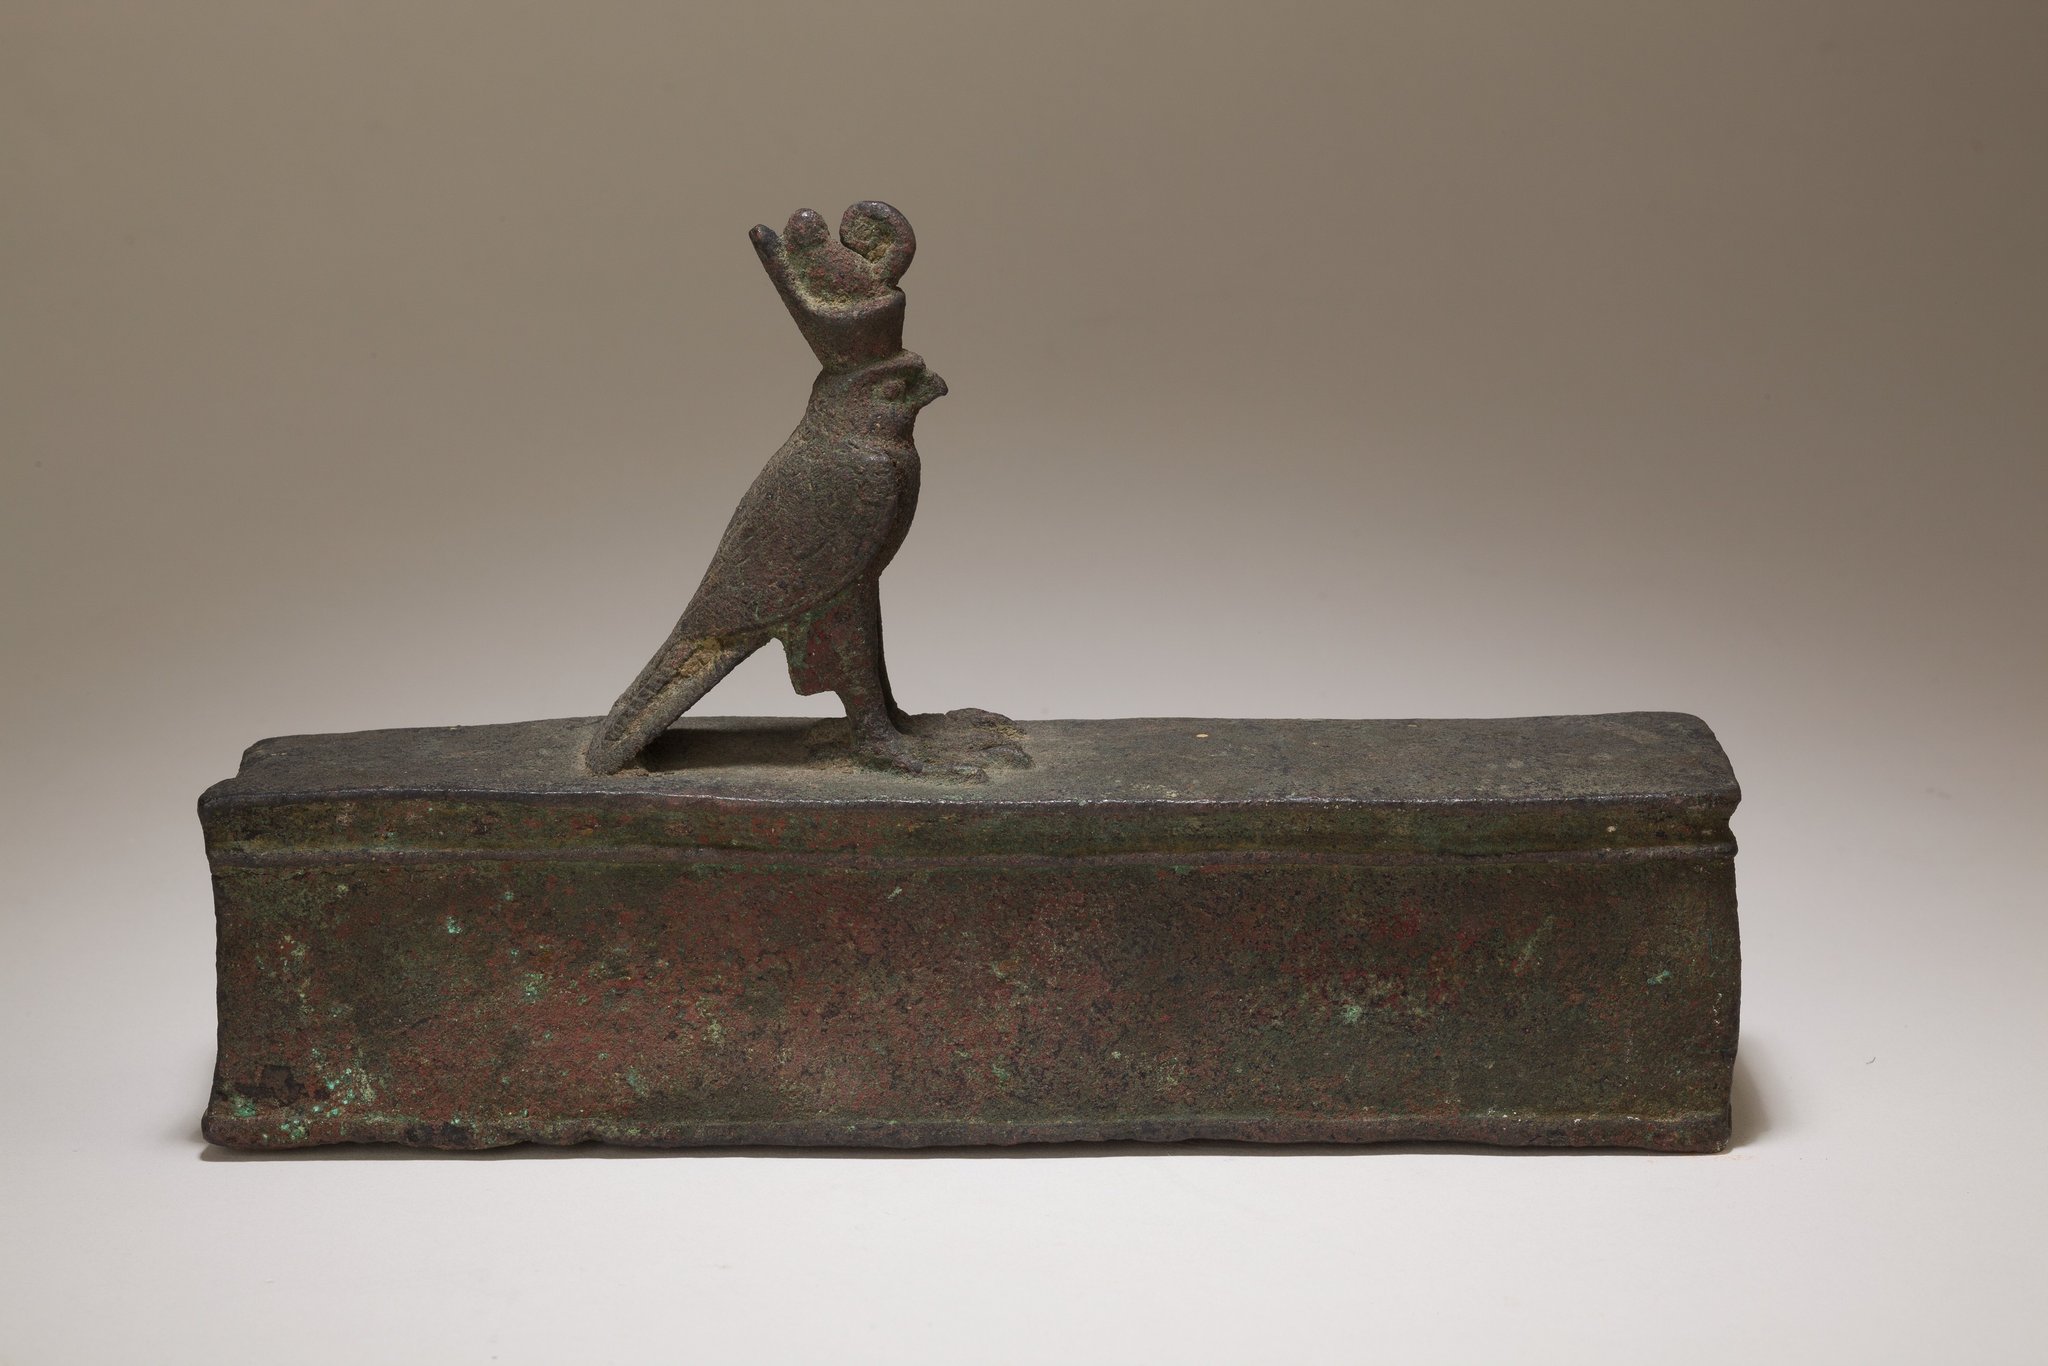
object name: mummy case, falcon, double crown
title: Case for an animal mummy topped by a falcon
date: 664-630 BCE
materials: metal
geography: egypt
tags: falcons,horus